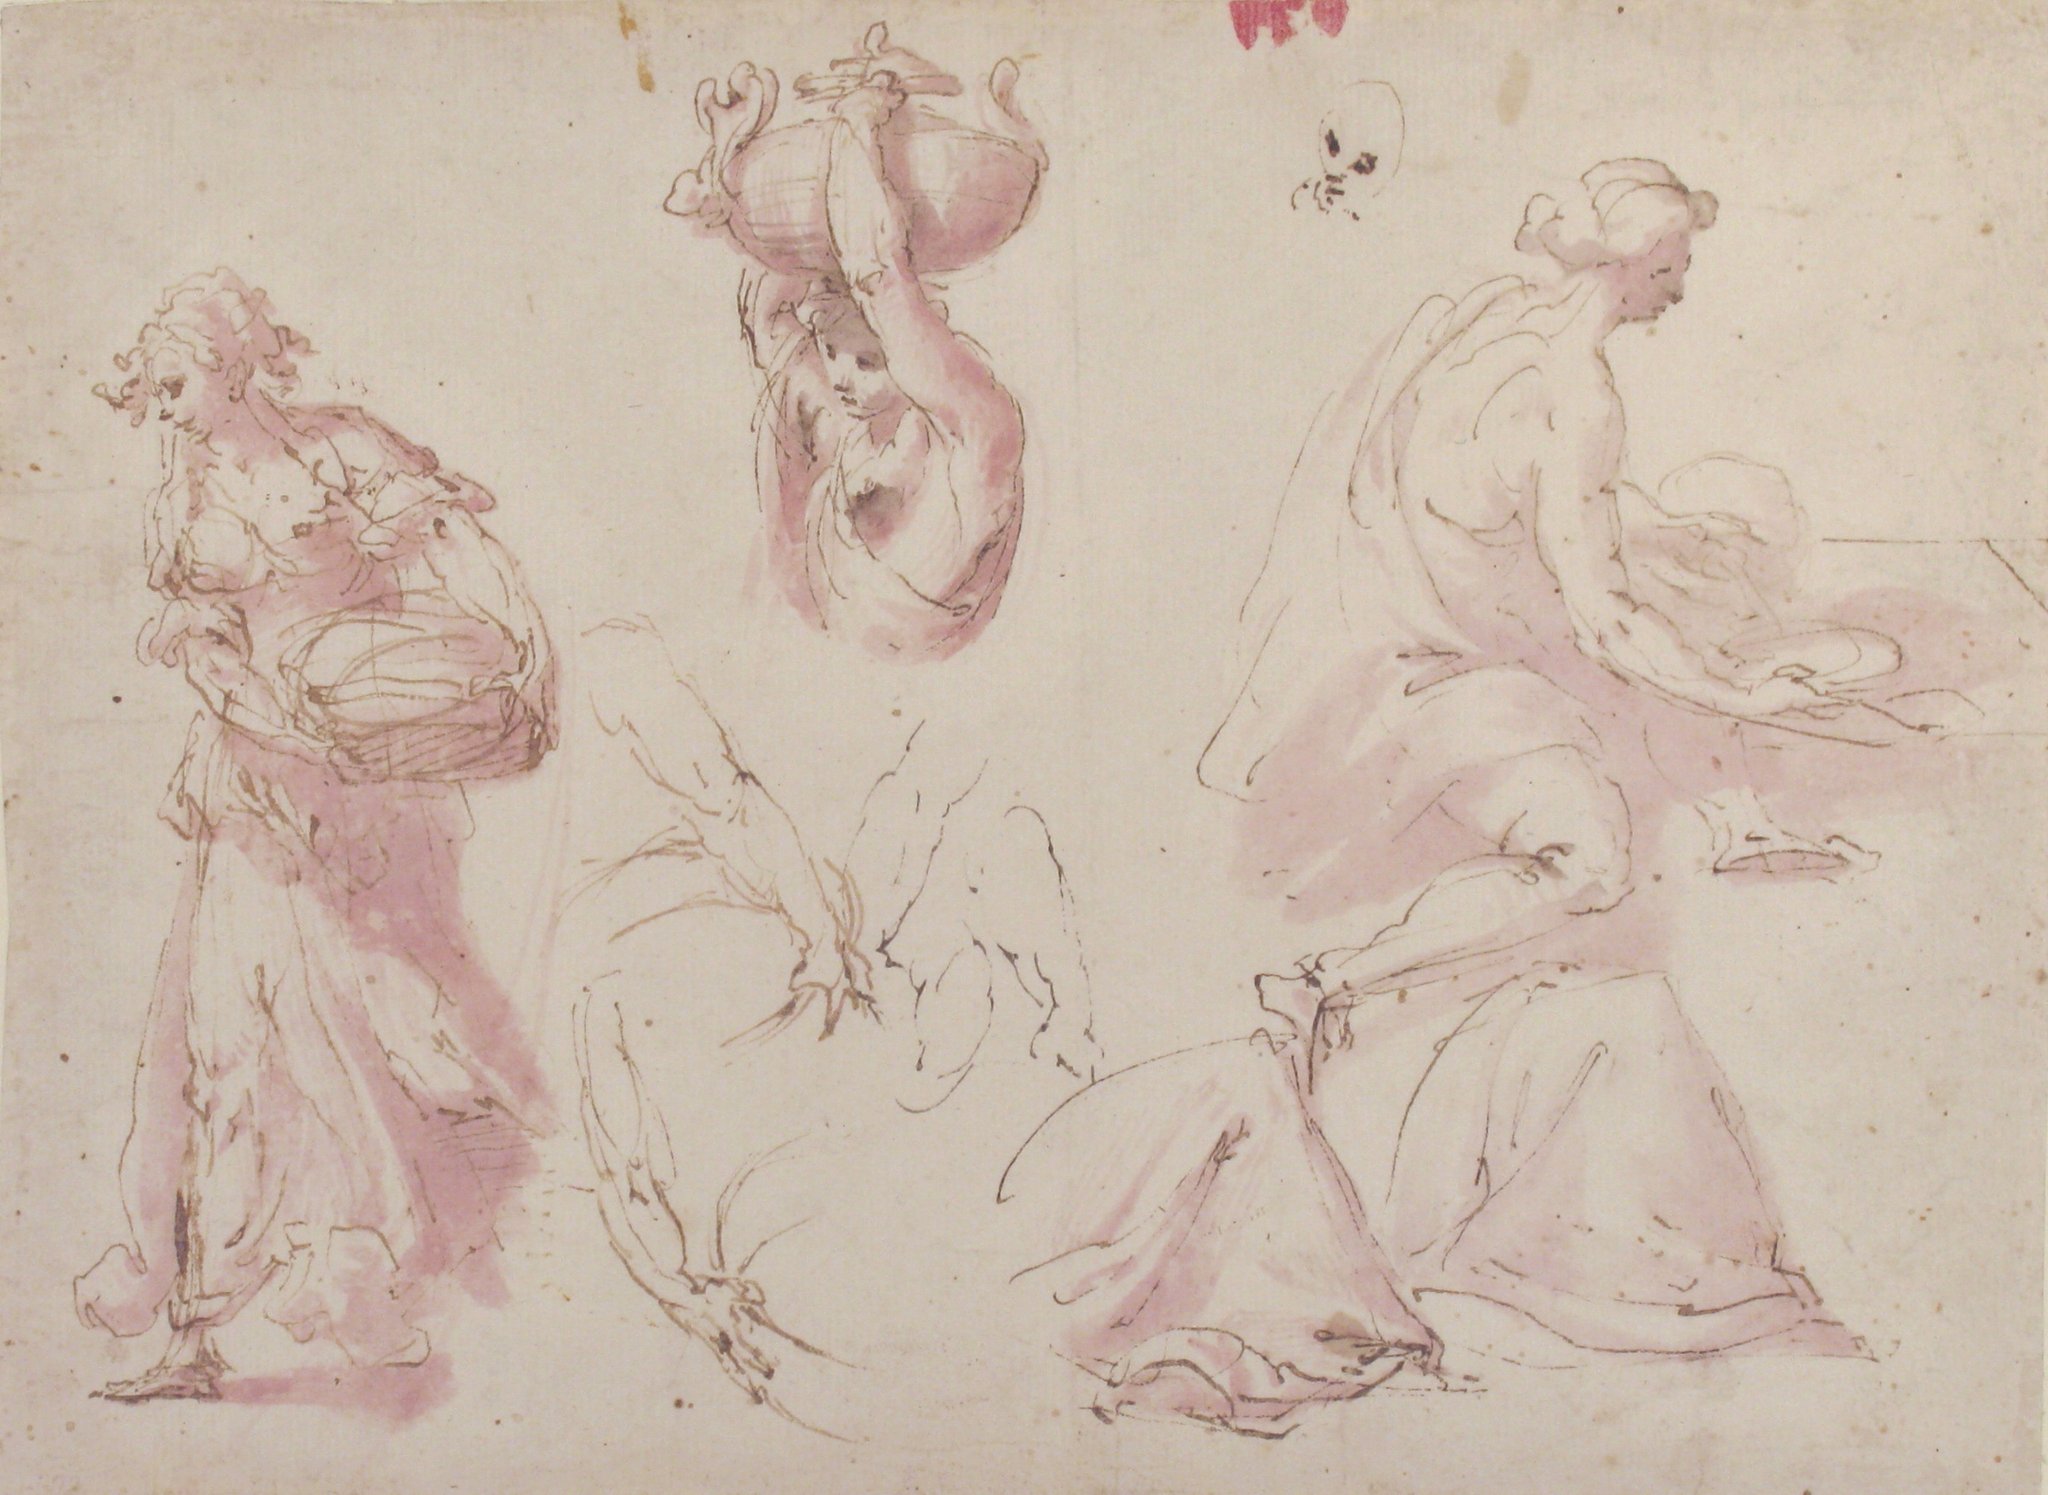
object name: drawing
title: Figure Studies: Woman Carrying a Basket; Woman Carrying a Vase, and Woman Seated at a Table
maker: francesco curia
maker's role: artist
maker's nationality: italian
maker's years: 1565-1608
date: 1565-1608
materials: ink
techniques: brush, pen, wash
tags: women,vases